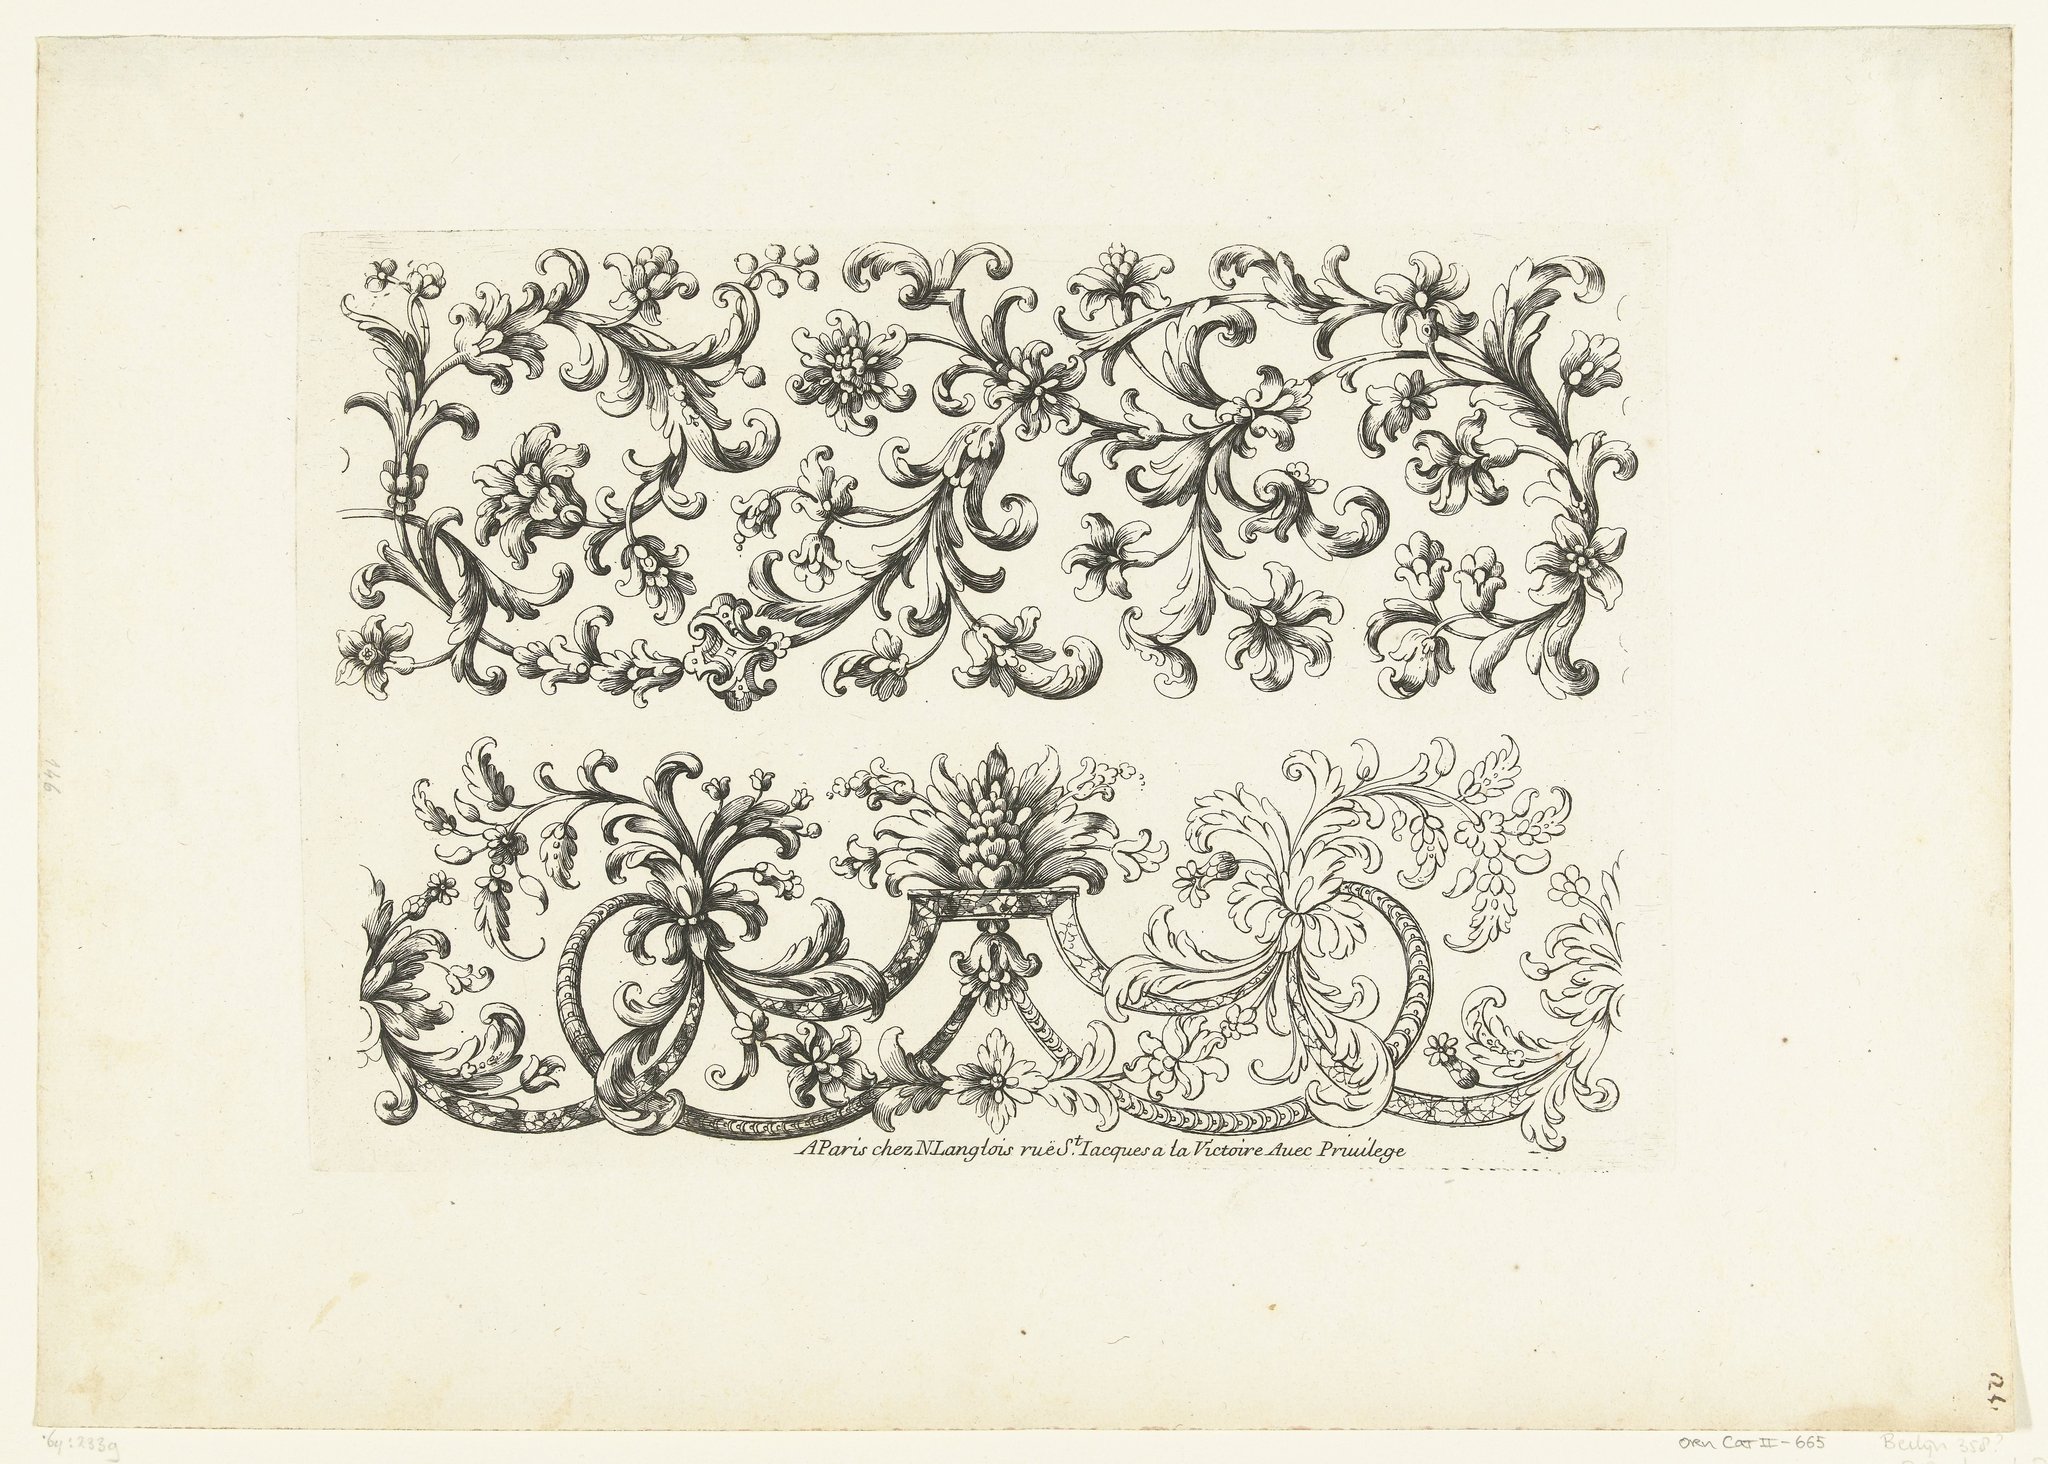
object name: ornament print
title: Twee friezen met ranken van rolwerk, bladeren en bloemen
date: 1670-1685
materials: paper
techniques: etching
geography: france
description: Het onderste fries is ontworpen langs een verticale as in het midden, van de rechterhelft is alleen het silhouet te zien.